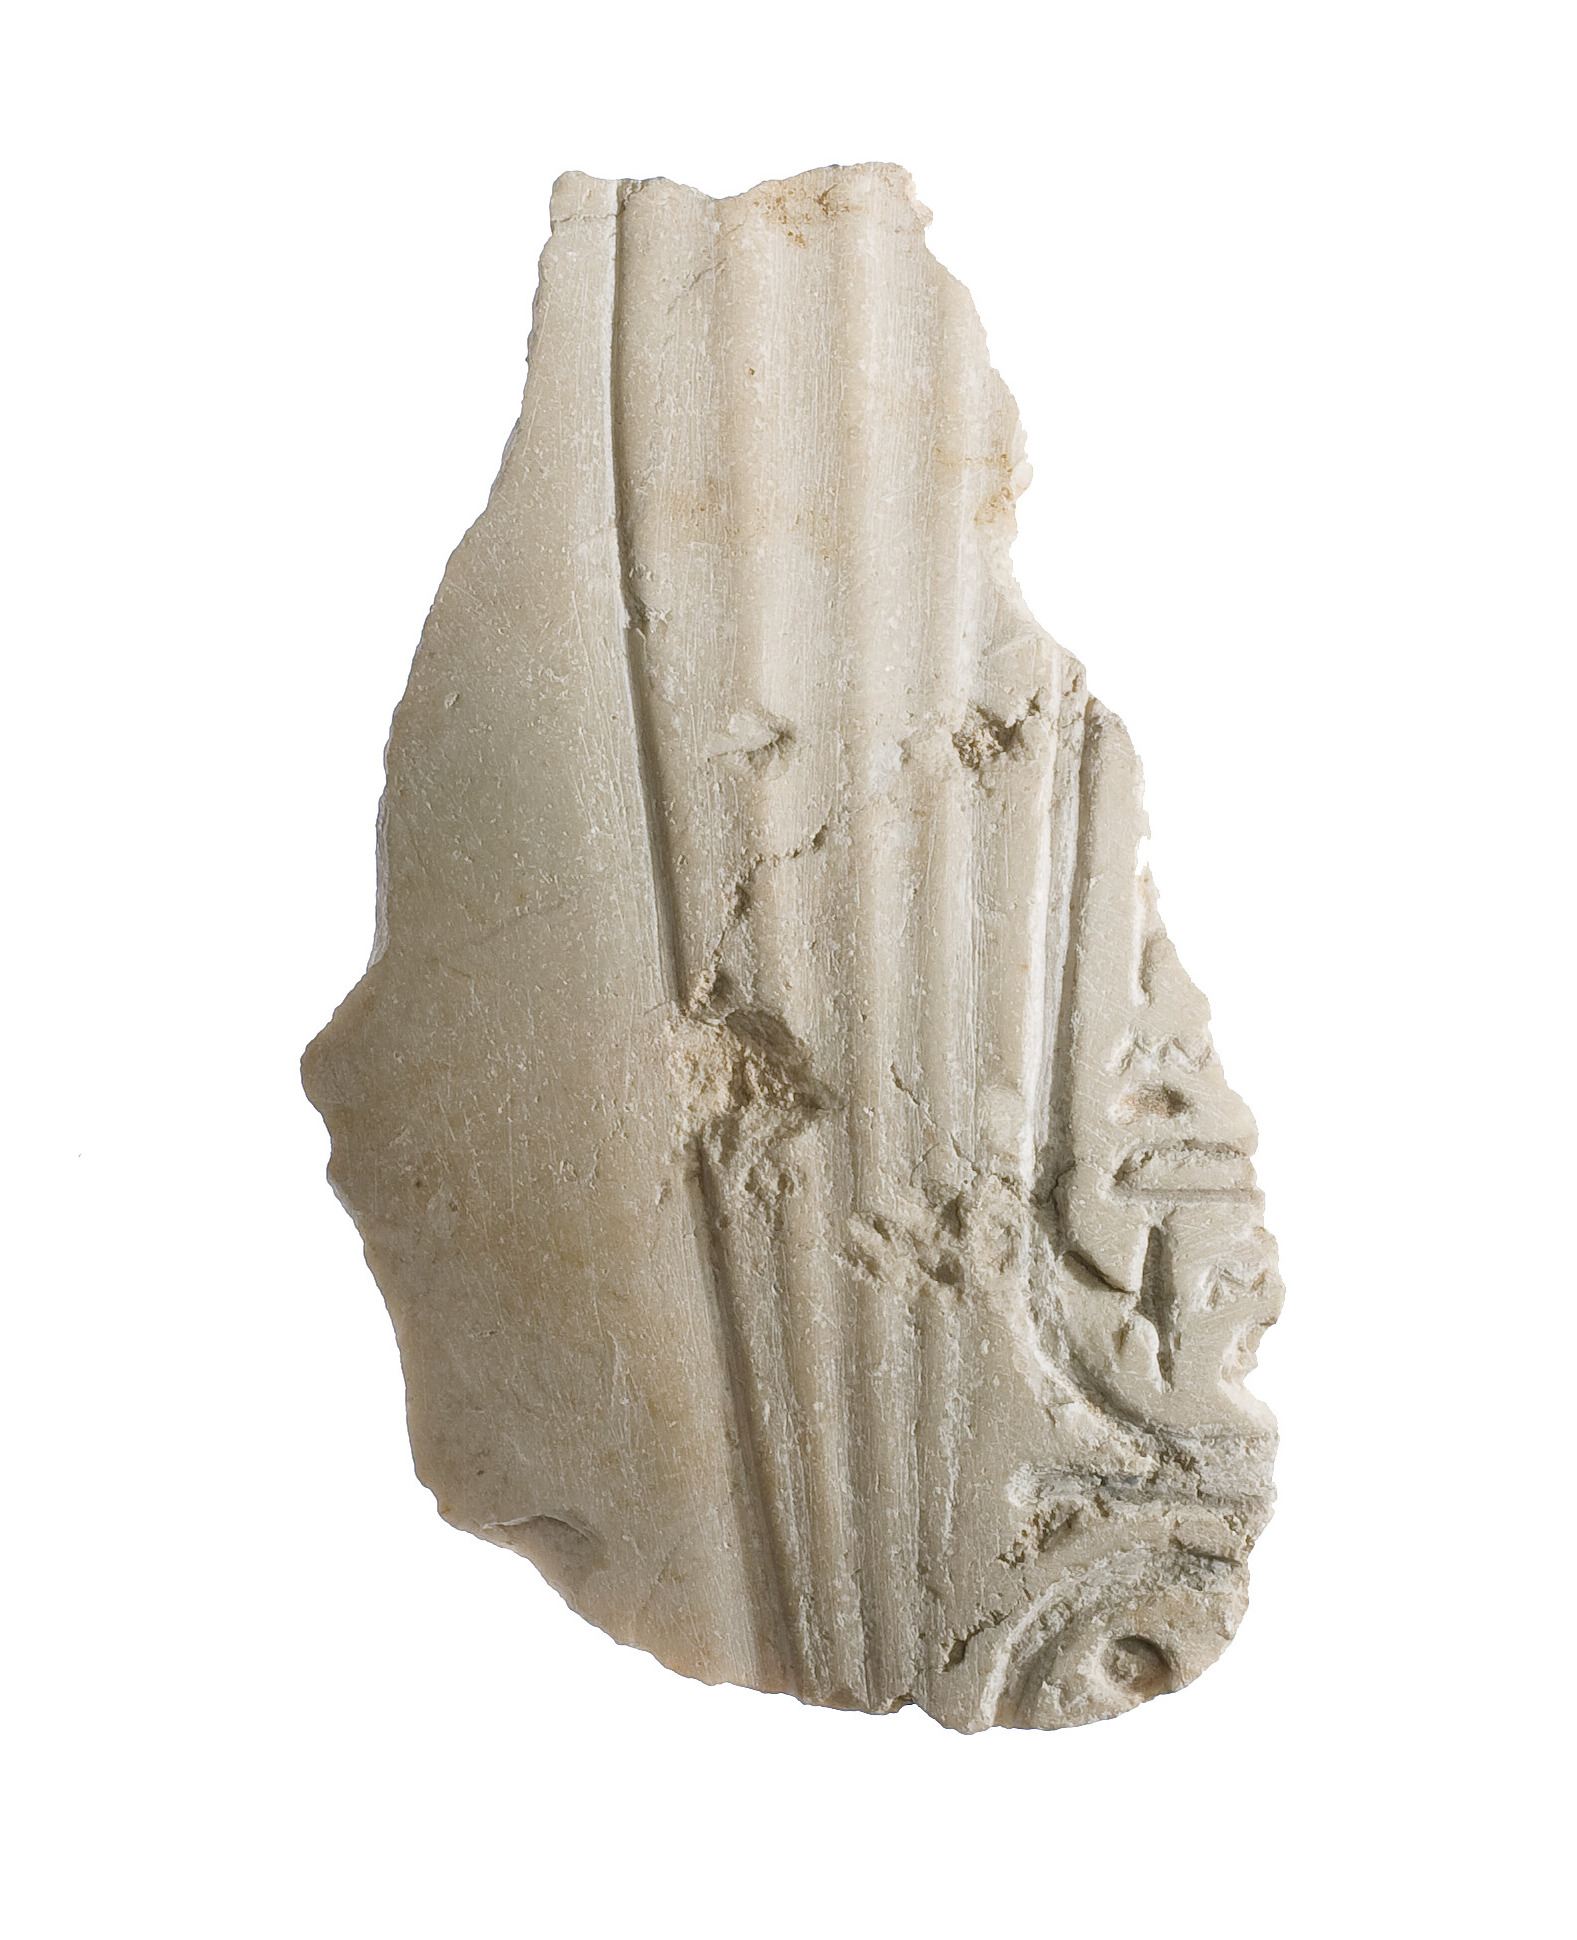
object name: akhenaten prostrate, belt, aten cartouche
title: Belt with Aten cartouche from Akhenaten prostrate (?)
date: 1352-1336 BCE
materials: limestone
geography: egypt